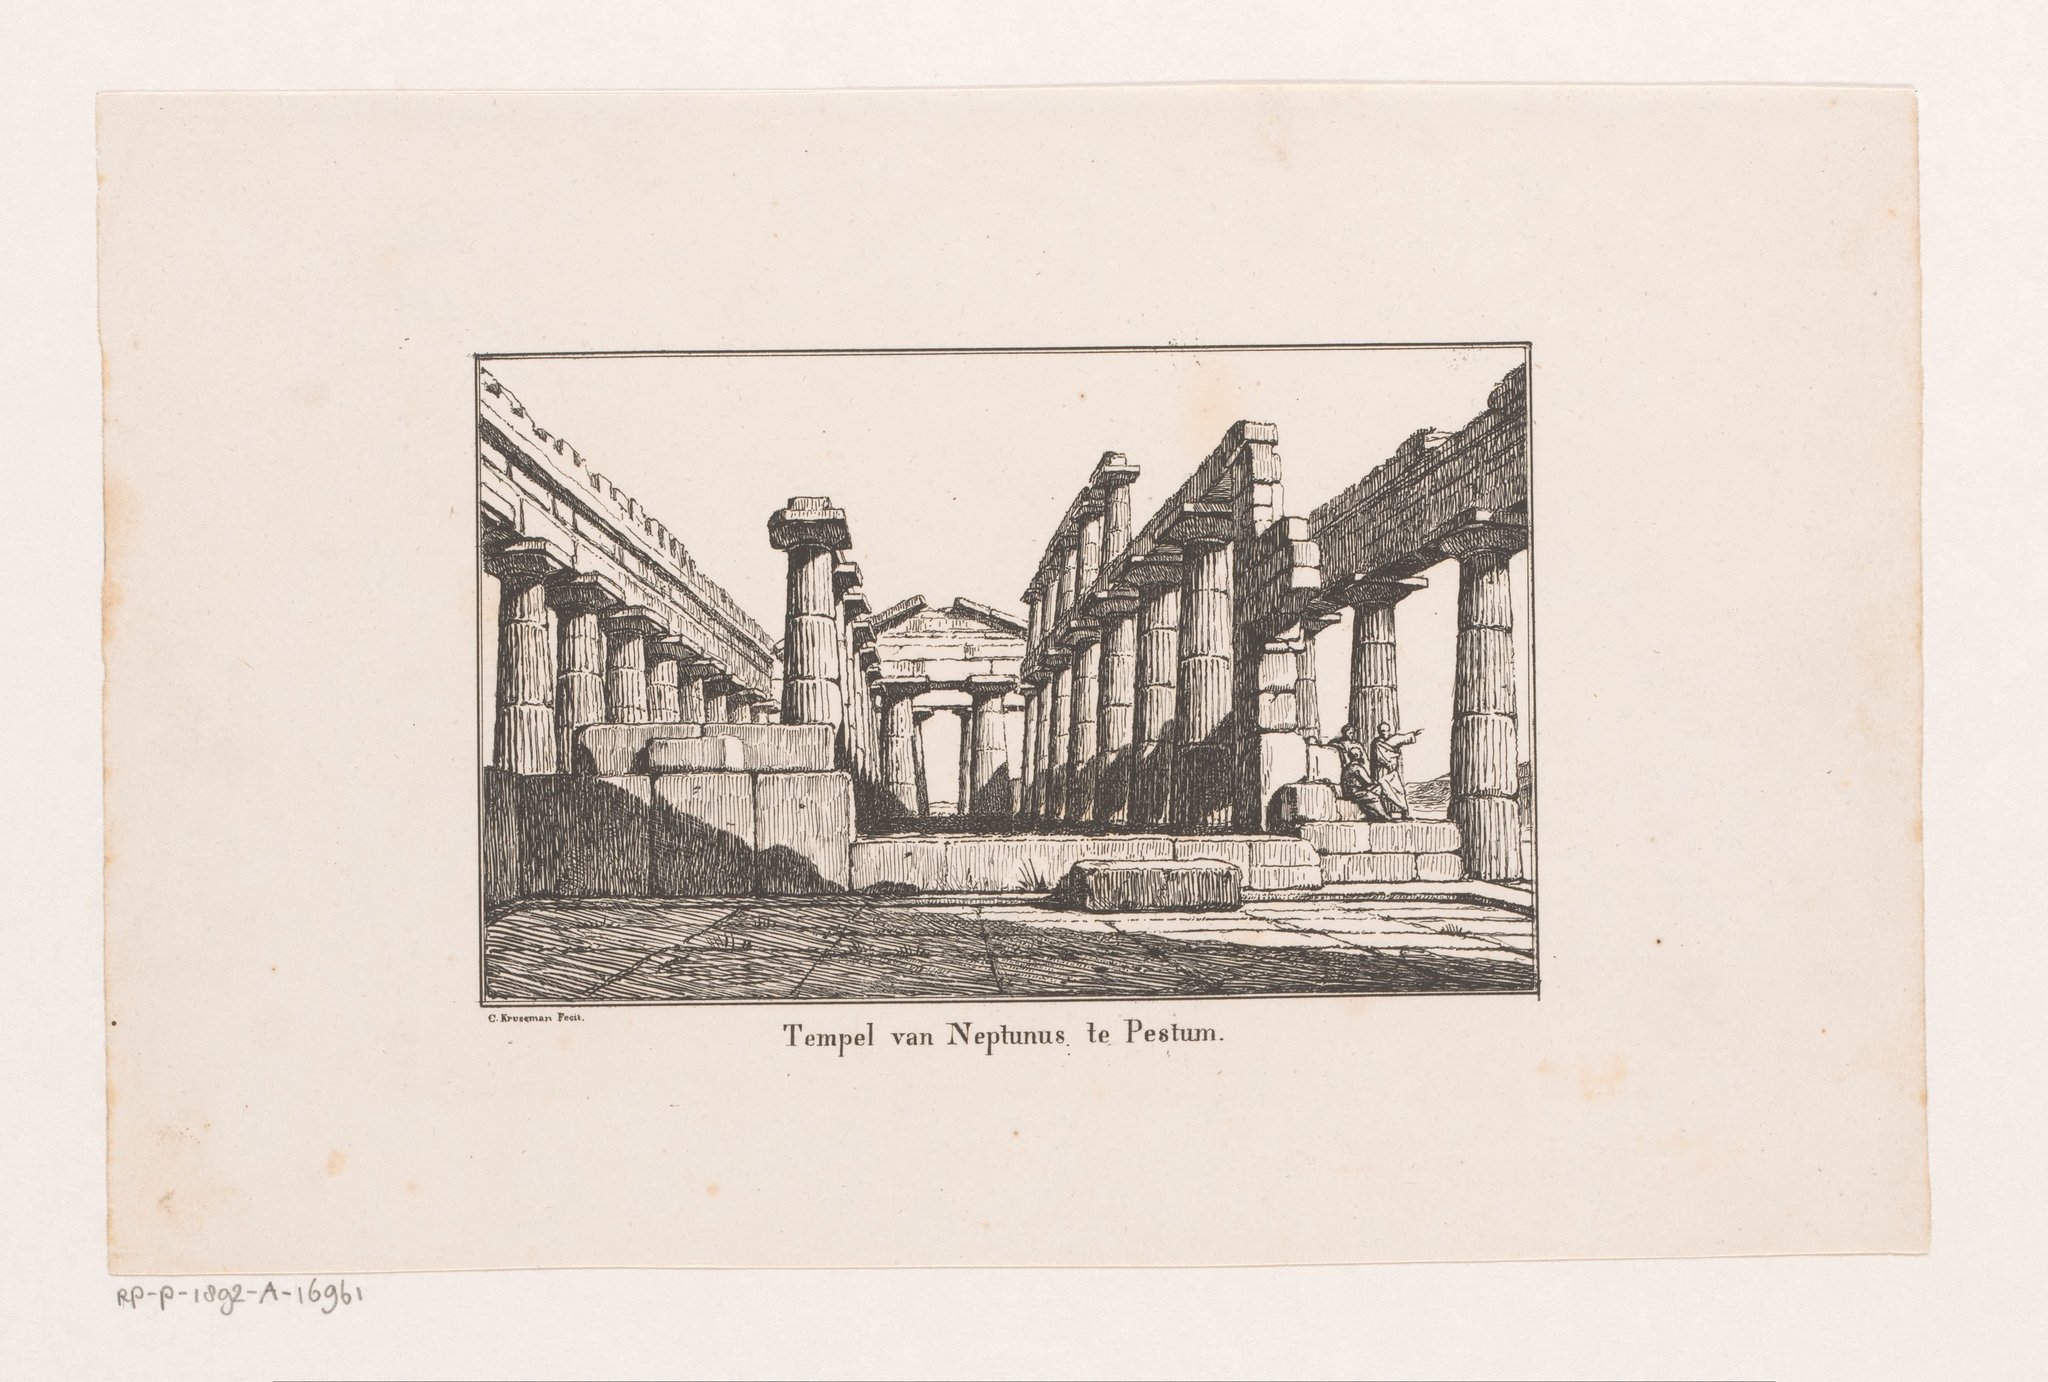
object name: print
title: Tempel van Neptunus te Pestum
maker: cornelis kruseman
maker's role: draughtsman, painter, print maker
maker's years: 1797-1857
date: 1809-1857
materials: paper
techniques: lithograph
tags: (story of) neptune (poseidon), temple, shrine ~ greek religion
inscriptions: collector's mark: Lugt 2228